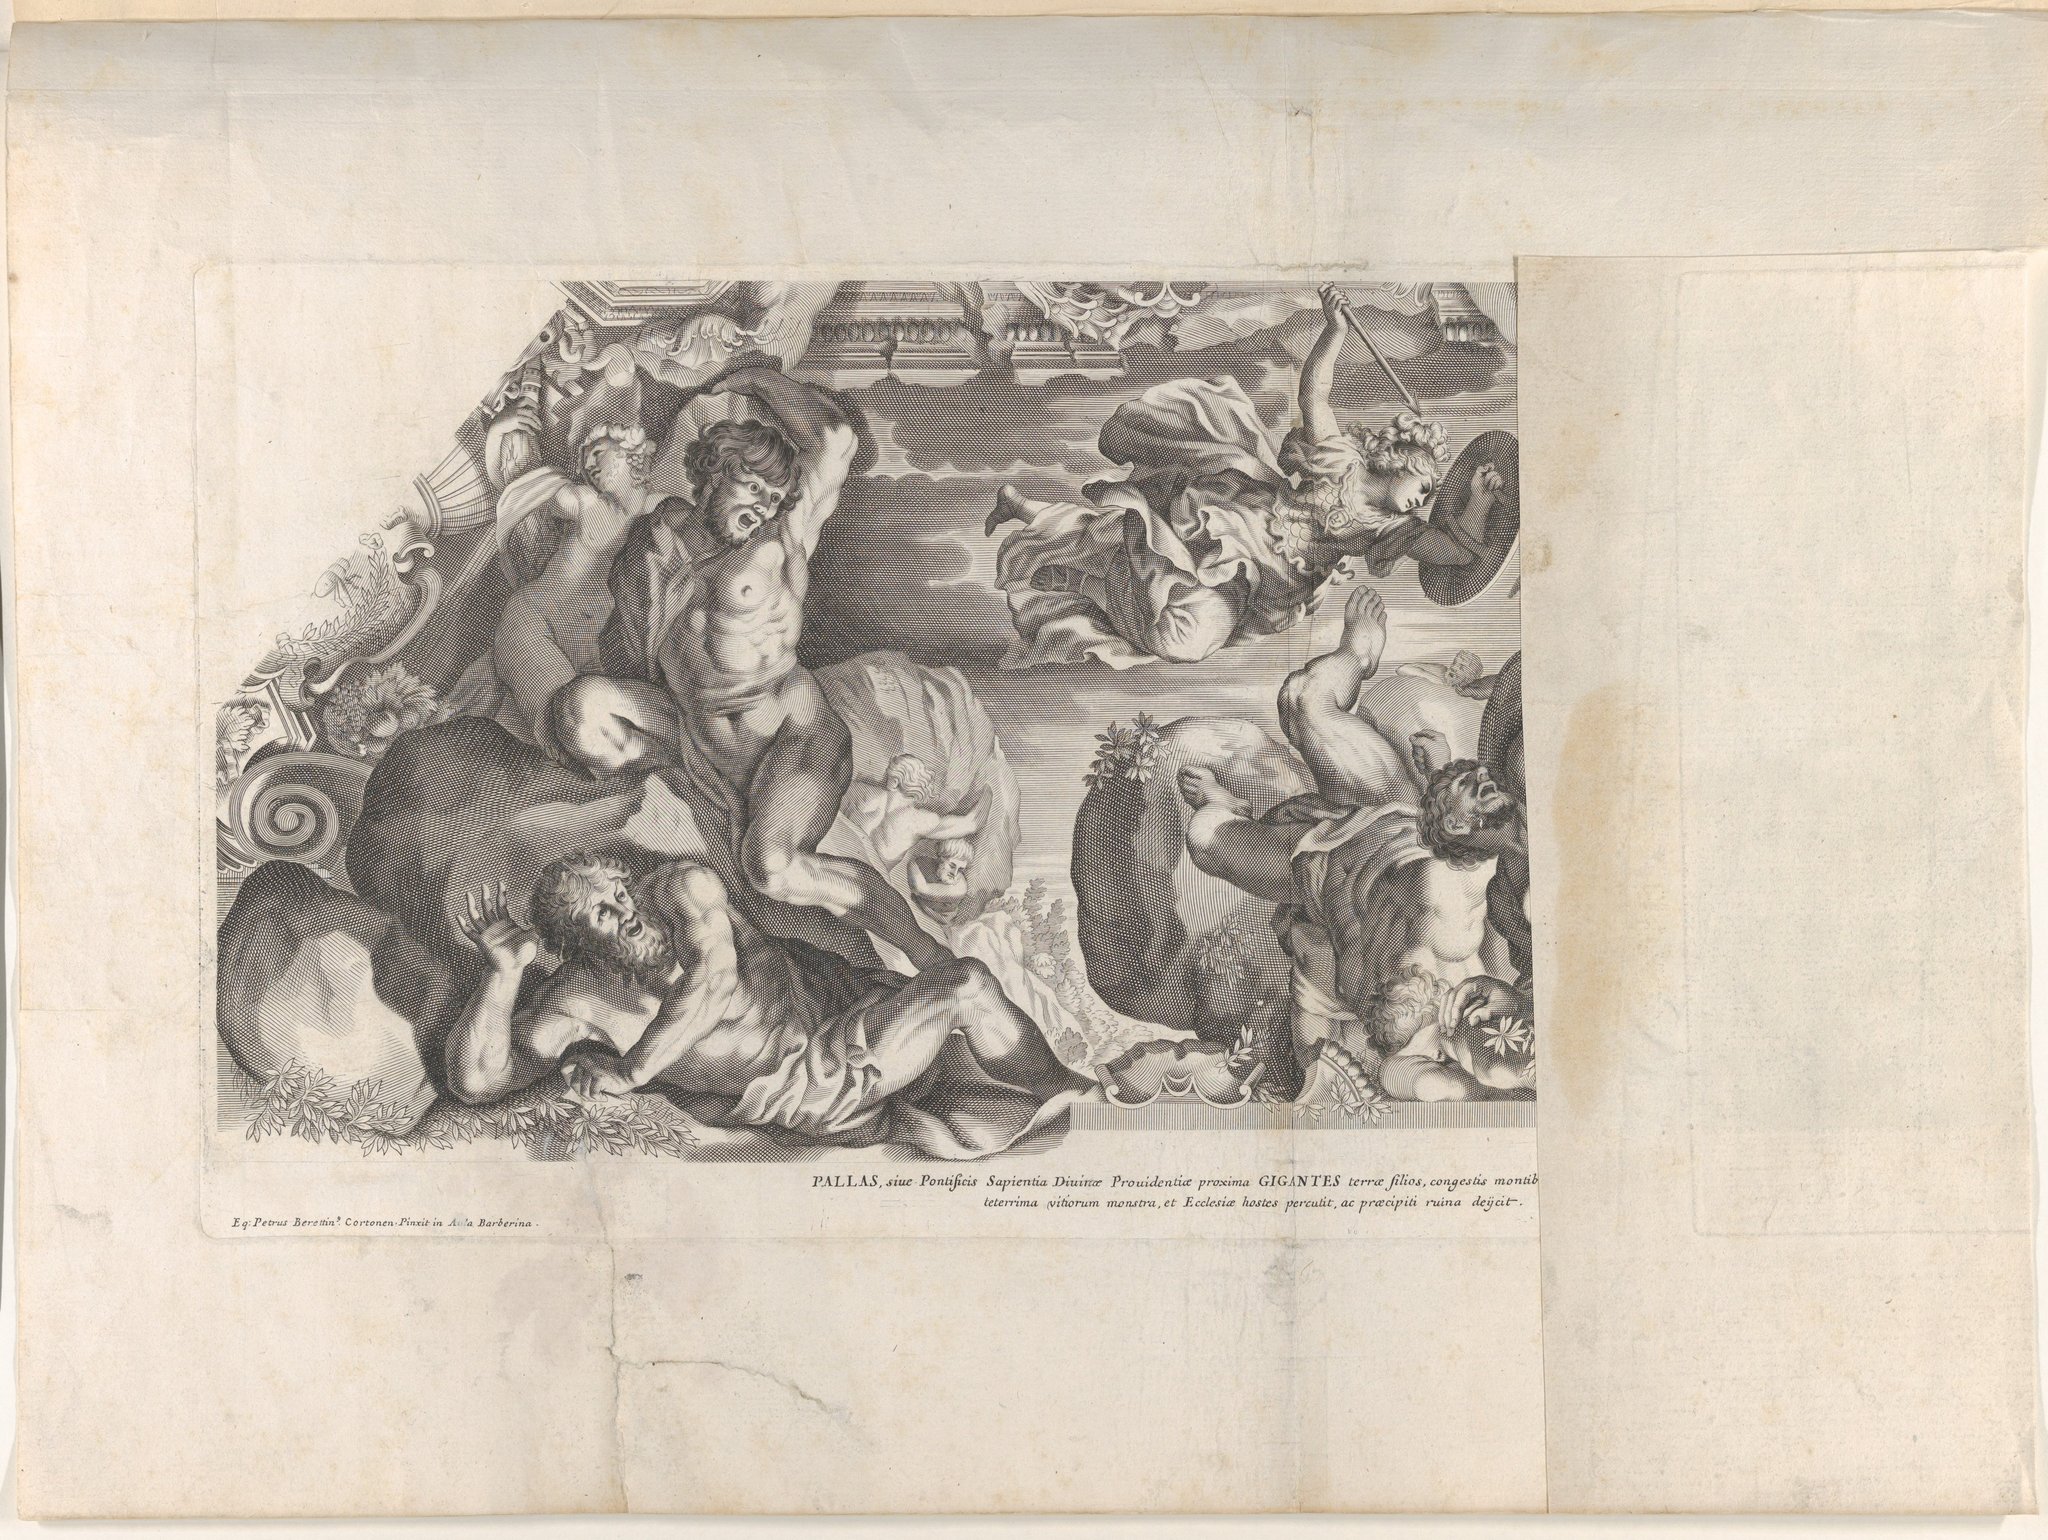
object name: print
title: Minerva depicted at top with a shield and arrow vanquishing the Giants below, from "Barberinae aulae fornix"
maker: anonymous, italian, 17th century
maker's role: artist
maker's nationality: italian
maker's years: 1600-1700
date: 1677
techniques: engraving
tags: men,minerva